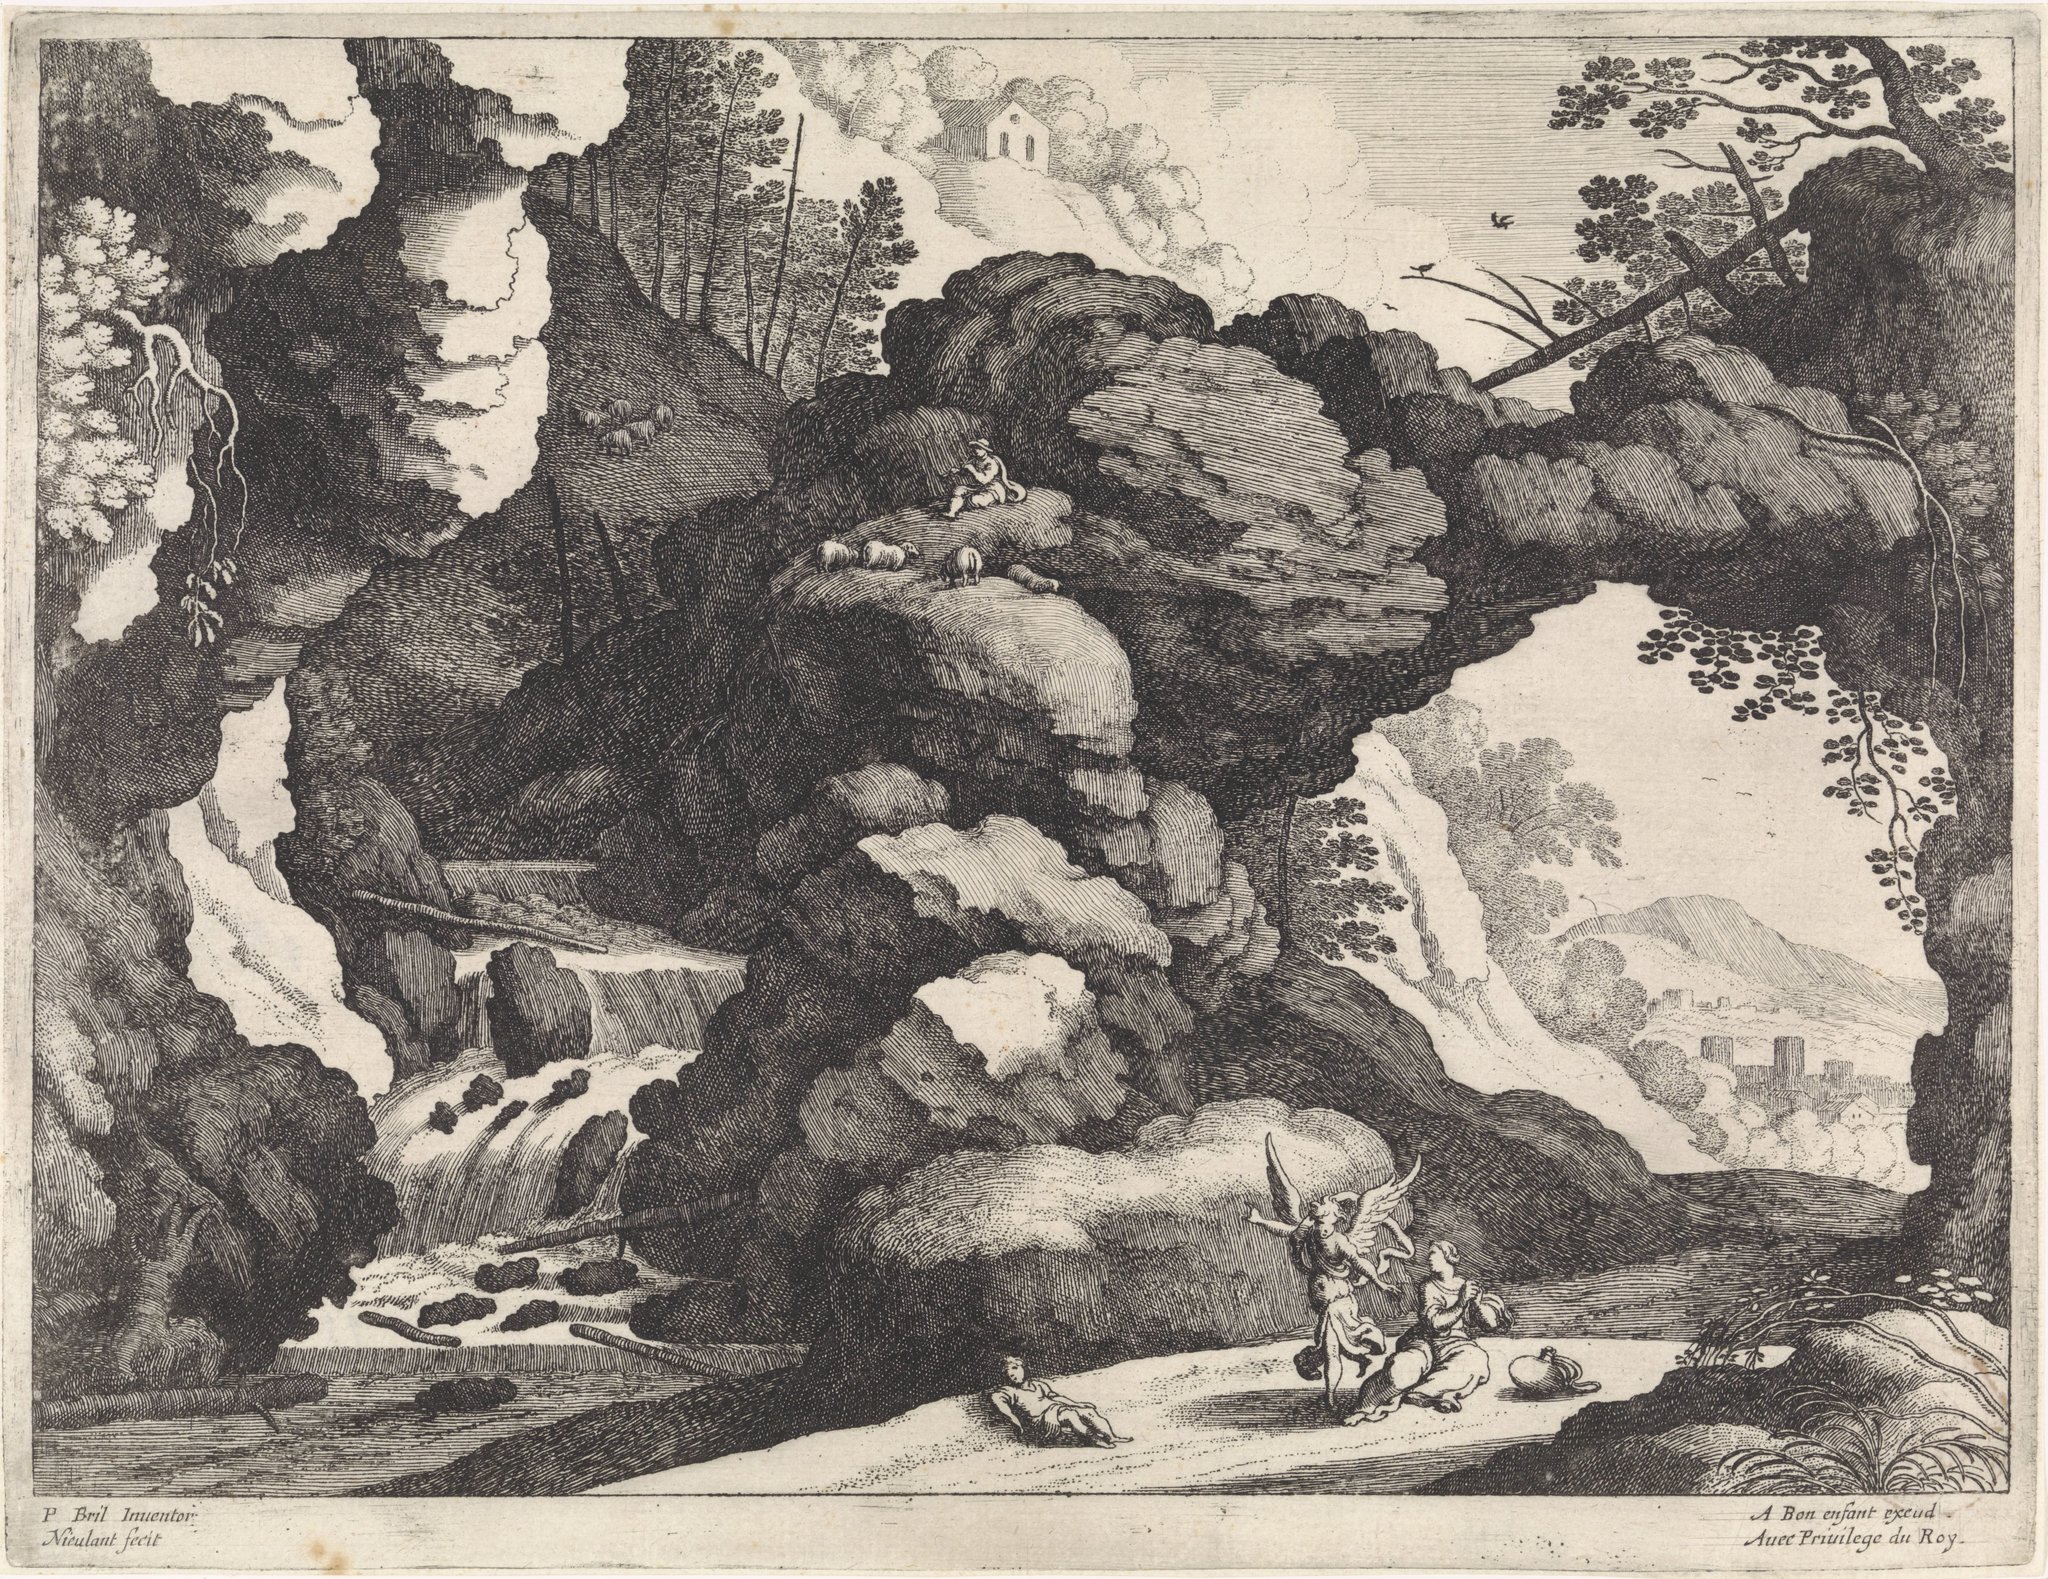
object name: print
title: Landschap met Hagar en Ismaël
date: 1594-1635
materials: paper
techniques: engraving, etching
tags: waterfall, an angel appears and reveals a well of water to hagar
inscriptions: collector's mark: Lugt 240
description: Hagar zit in wanhoop op de grond met de lege kruik naast zich. Haar zoon Ismaël ligt naast haar. Een engel redt Hagar door haar te wijzen op de waterval. Boven op de boogvormige rots zit een herder met zijn schapen. Prent uit een serie Italiaanse landschappen.